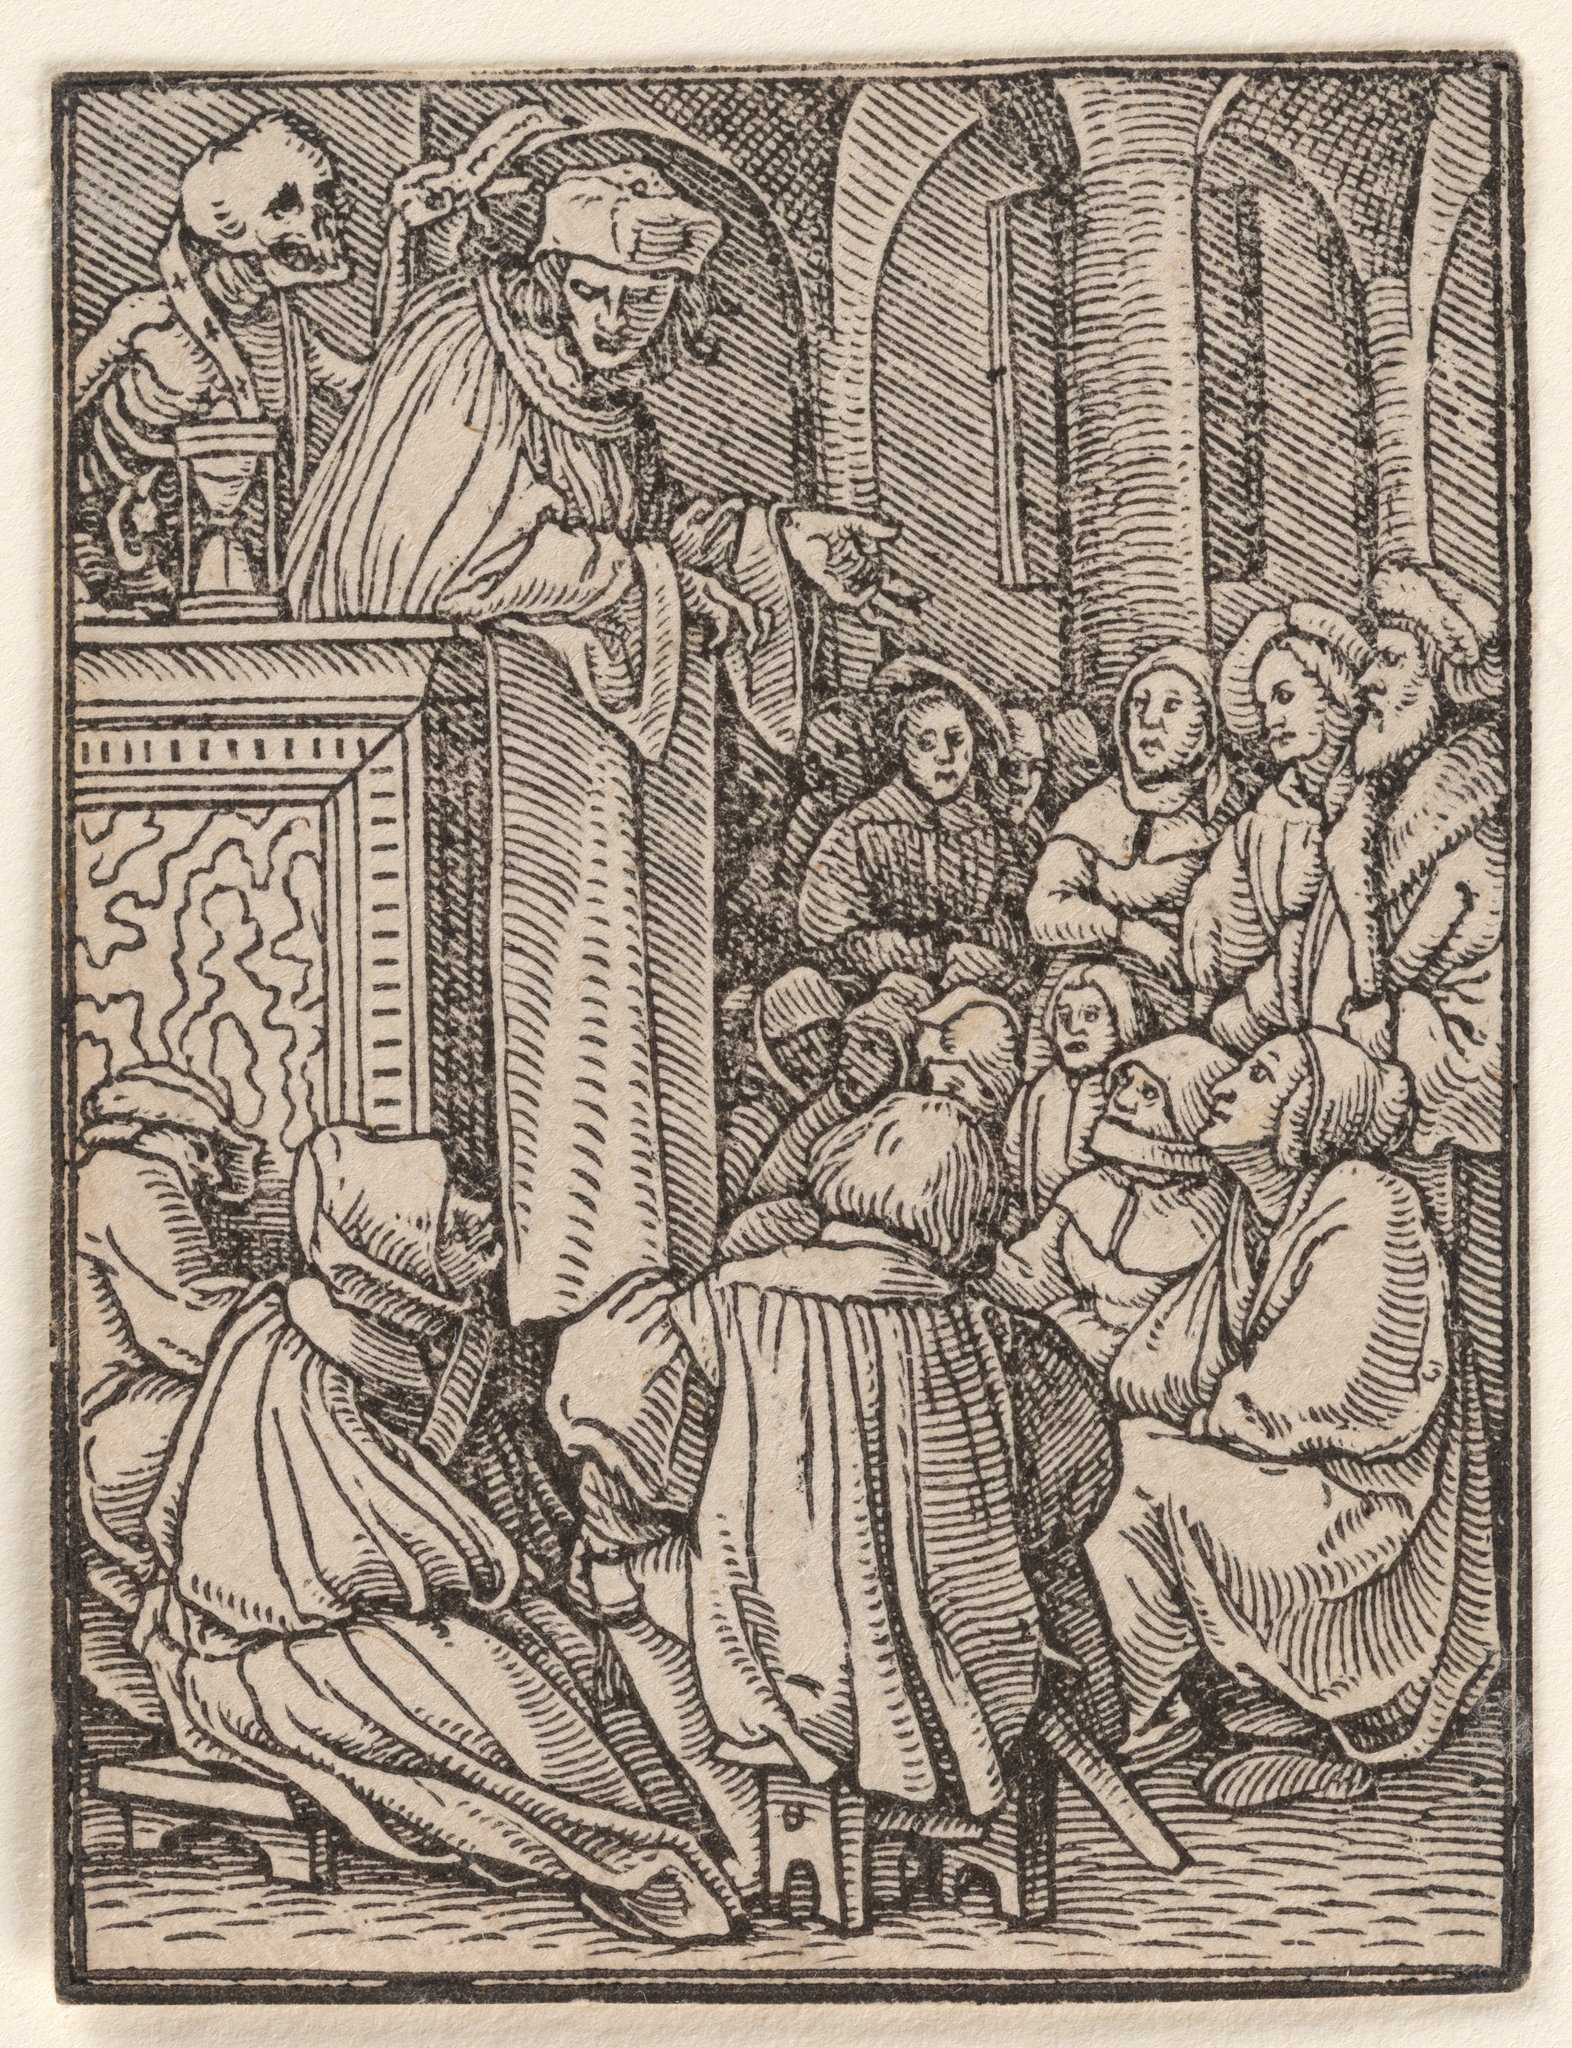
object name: print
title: The Clergyman, from The Dance of Death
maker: hans holbein the younger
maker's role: artist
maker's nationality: german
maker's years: 1497-1543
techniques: woodcut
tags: skeletons,men